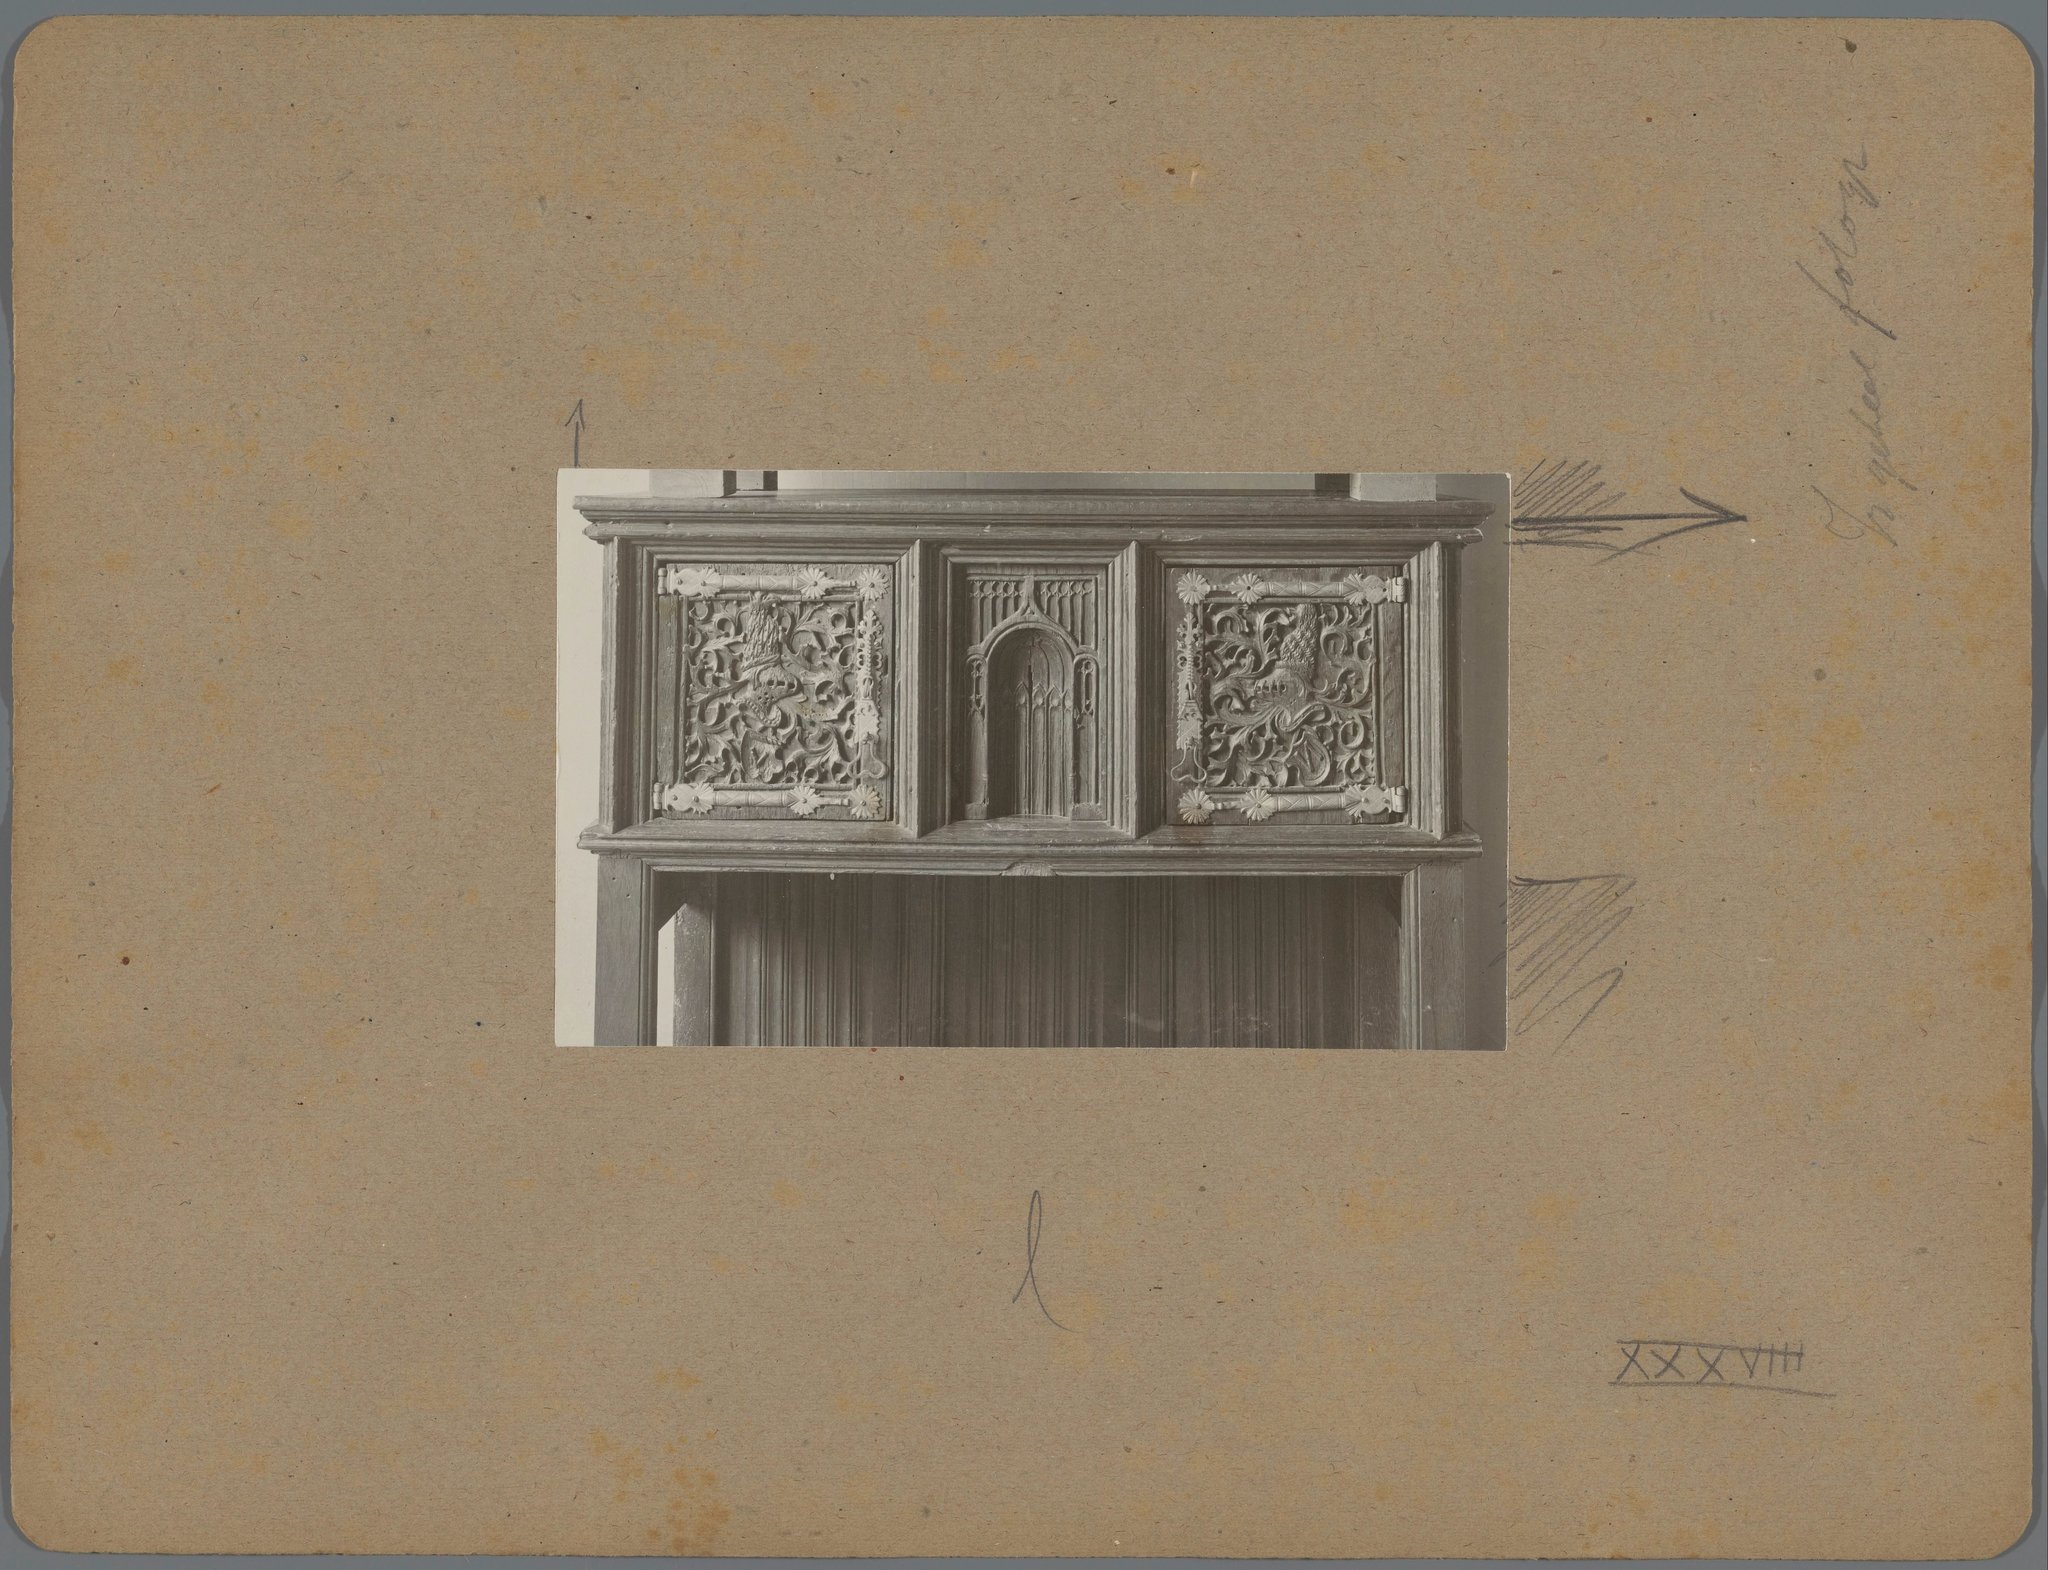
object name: photograph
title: Detail van een kast met twee deurtjes geornamenteerd met plantmotieven en dierenkoppen en in het midden een nis-vorm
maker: Anonymous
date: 1875-1900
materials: cardboard, photographic support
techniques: gelatin silver print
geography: europe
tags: ornament ~ hybrid animals, cupboard, ornament derived from plant forms, amsterdam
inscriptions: collector's mark: ‘KUNSTNIJVERHEIDSCHOOL QUELLINUS AMSTERDAM FRANS HALSSTRAAT 14.’, collector's mark: ‘INSTITUUT VOOR KUNST-NIJVERHEIDSONDERWIJS GABRIËL METSUSTRAAT No. 16 AMSTERDAM’, number: ‘XXXVIII’